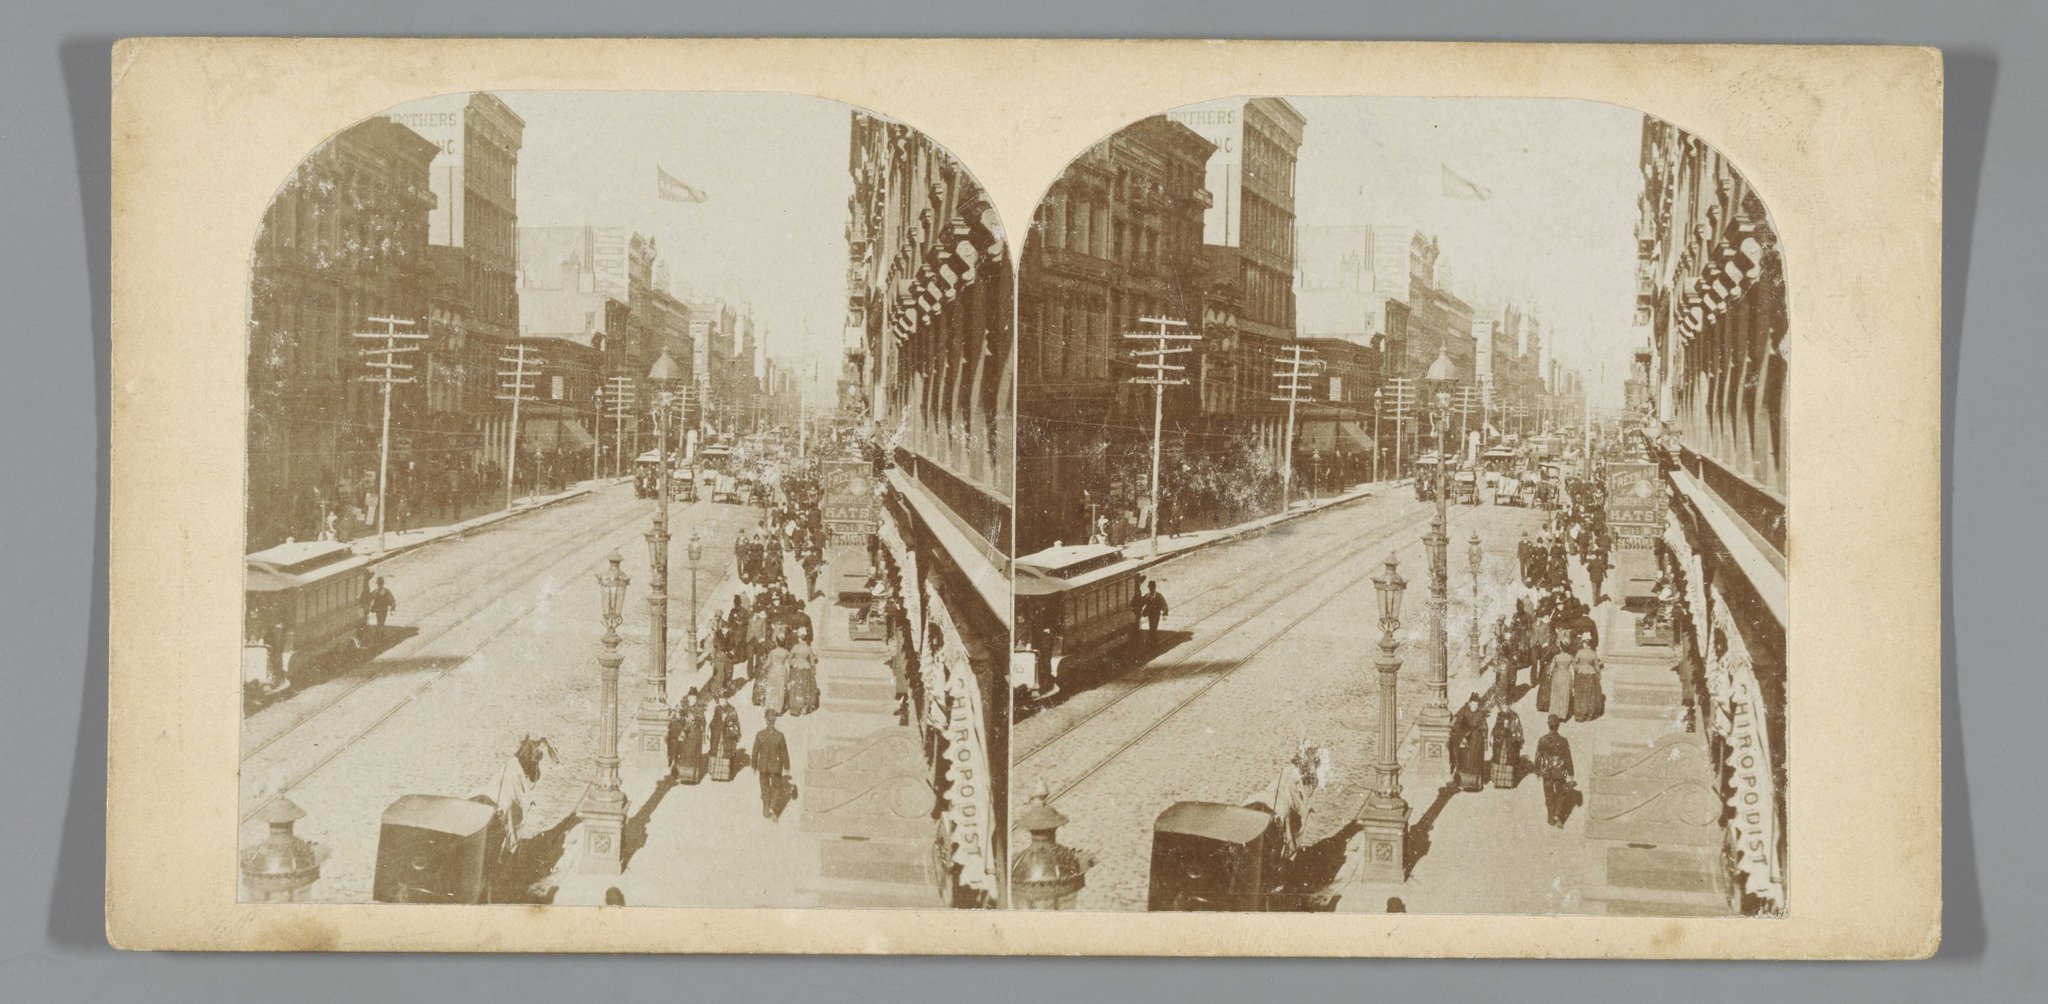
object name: stereograph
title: Gezicht op Broadway, New York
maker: Anonymous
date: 1879-1910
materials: paper, cardboard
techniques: collodion silver print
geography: new york city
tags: city-view in general; 'veduta', new york (city)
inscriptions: number: ‘35’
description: Reclame voor 'Freeman Brothers hats, 594 Broadway' aan gevel rechterzijde onderin foto.